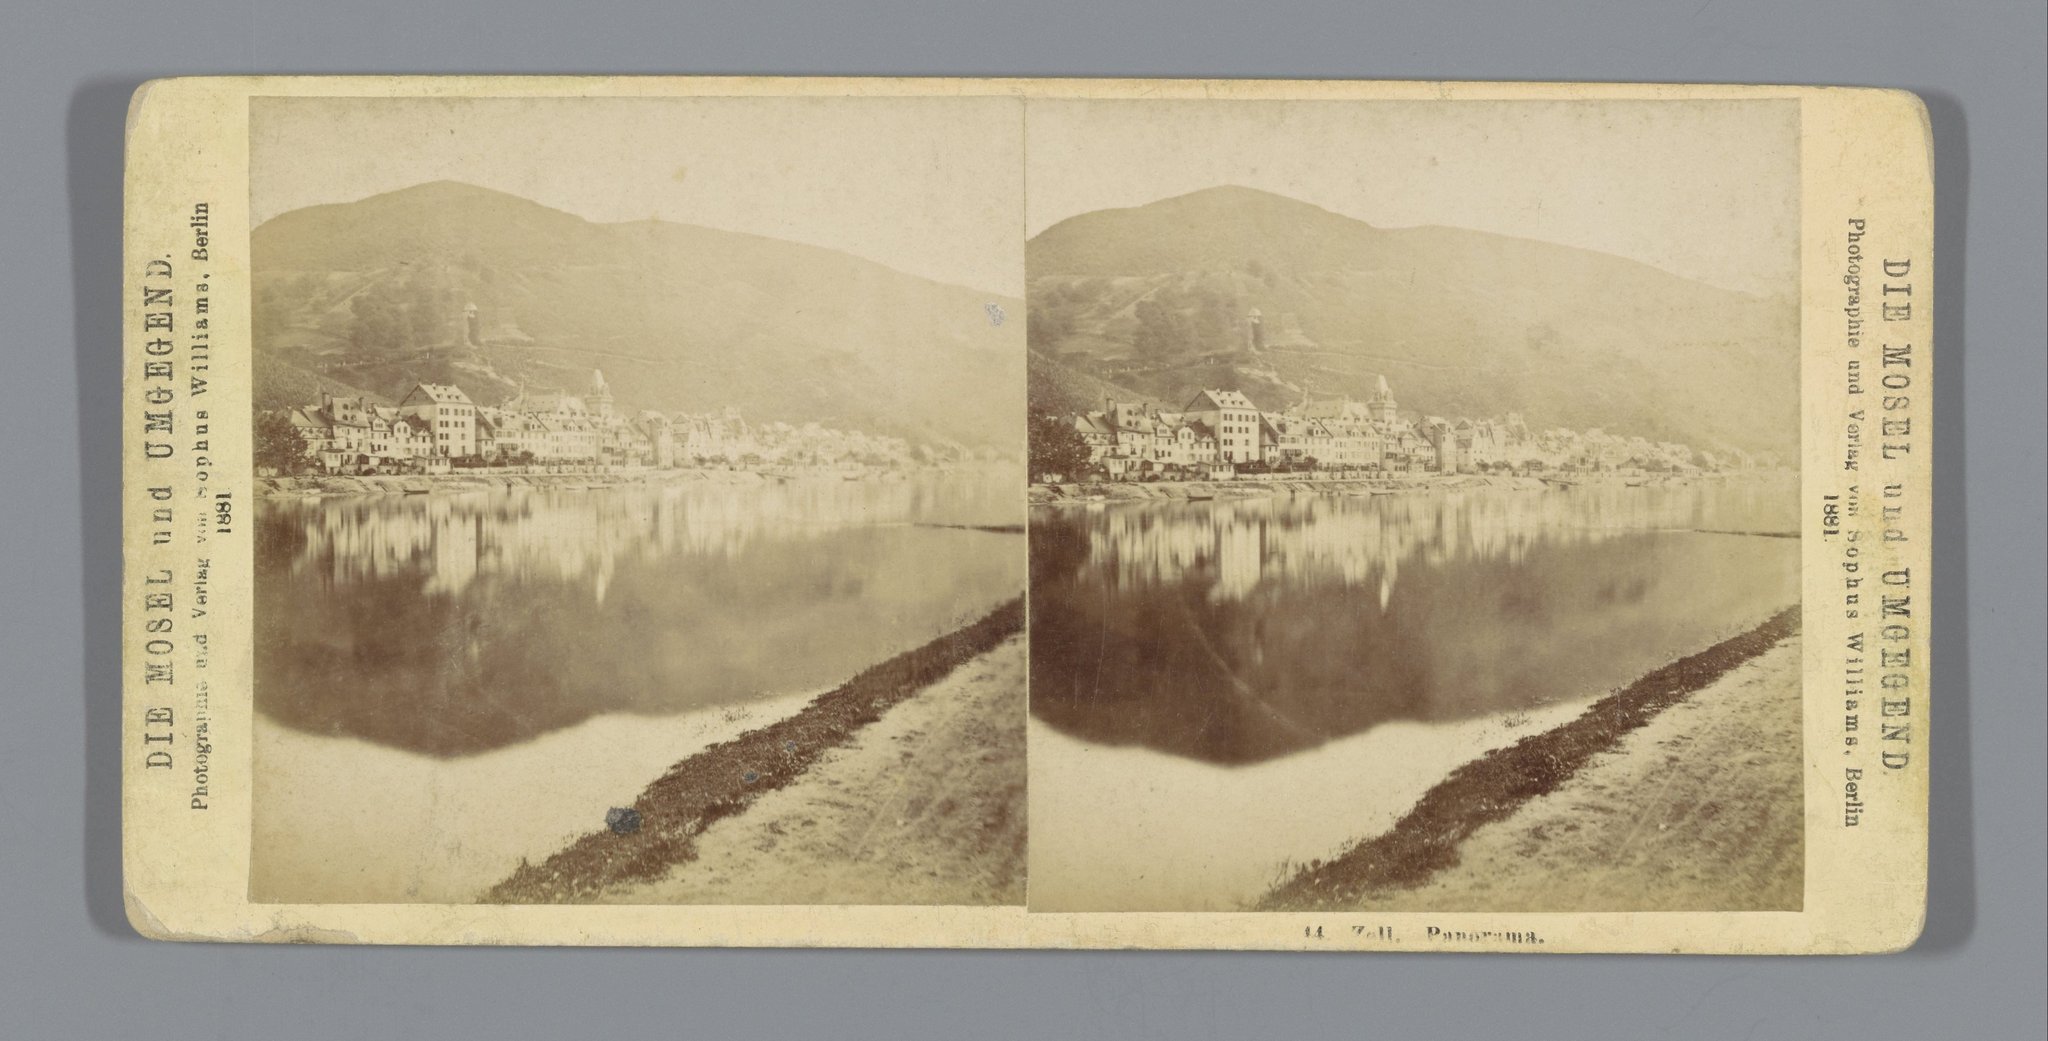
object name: stereograph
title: Zell. Panorama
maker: sophus williams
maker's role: publisher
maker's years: 1835-1900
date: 1881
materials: cardboard, photographic support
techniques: albumen print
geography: berlin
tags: city-view in general; 'veduta', river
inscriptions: number: ‘14.’